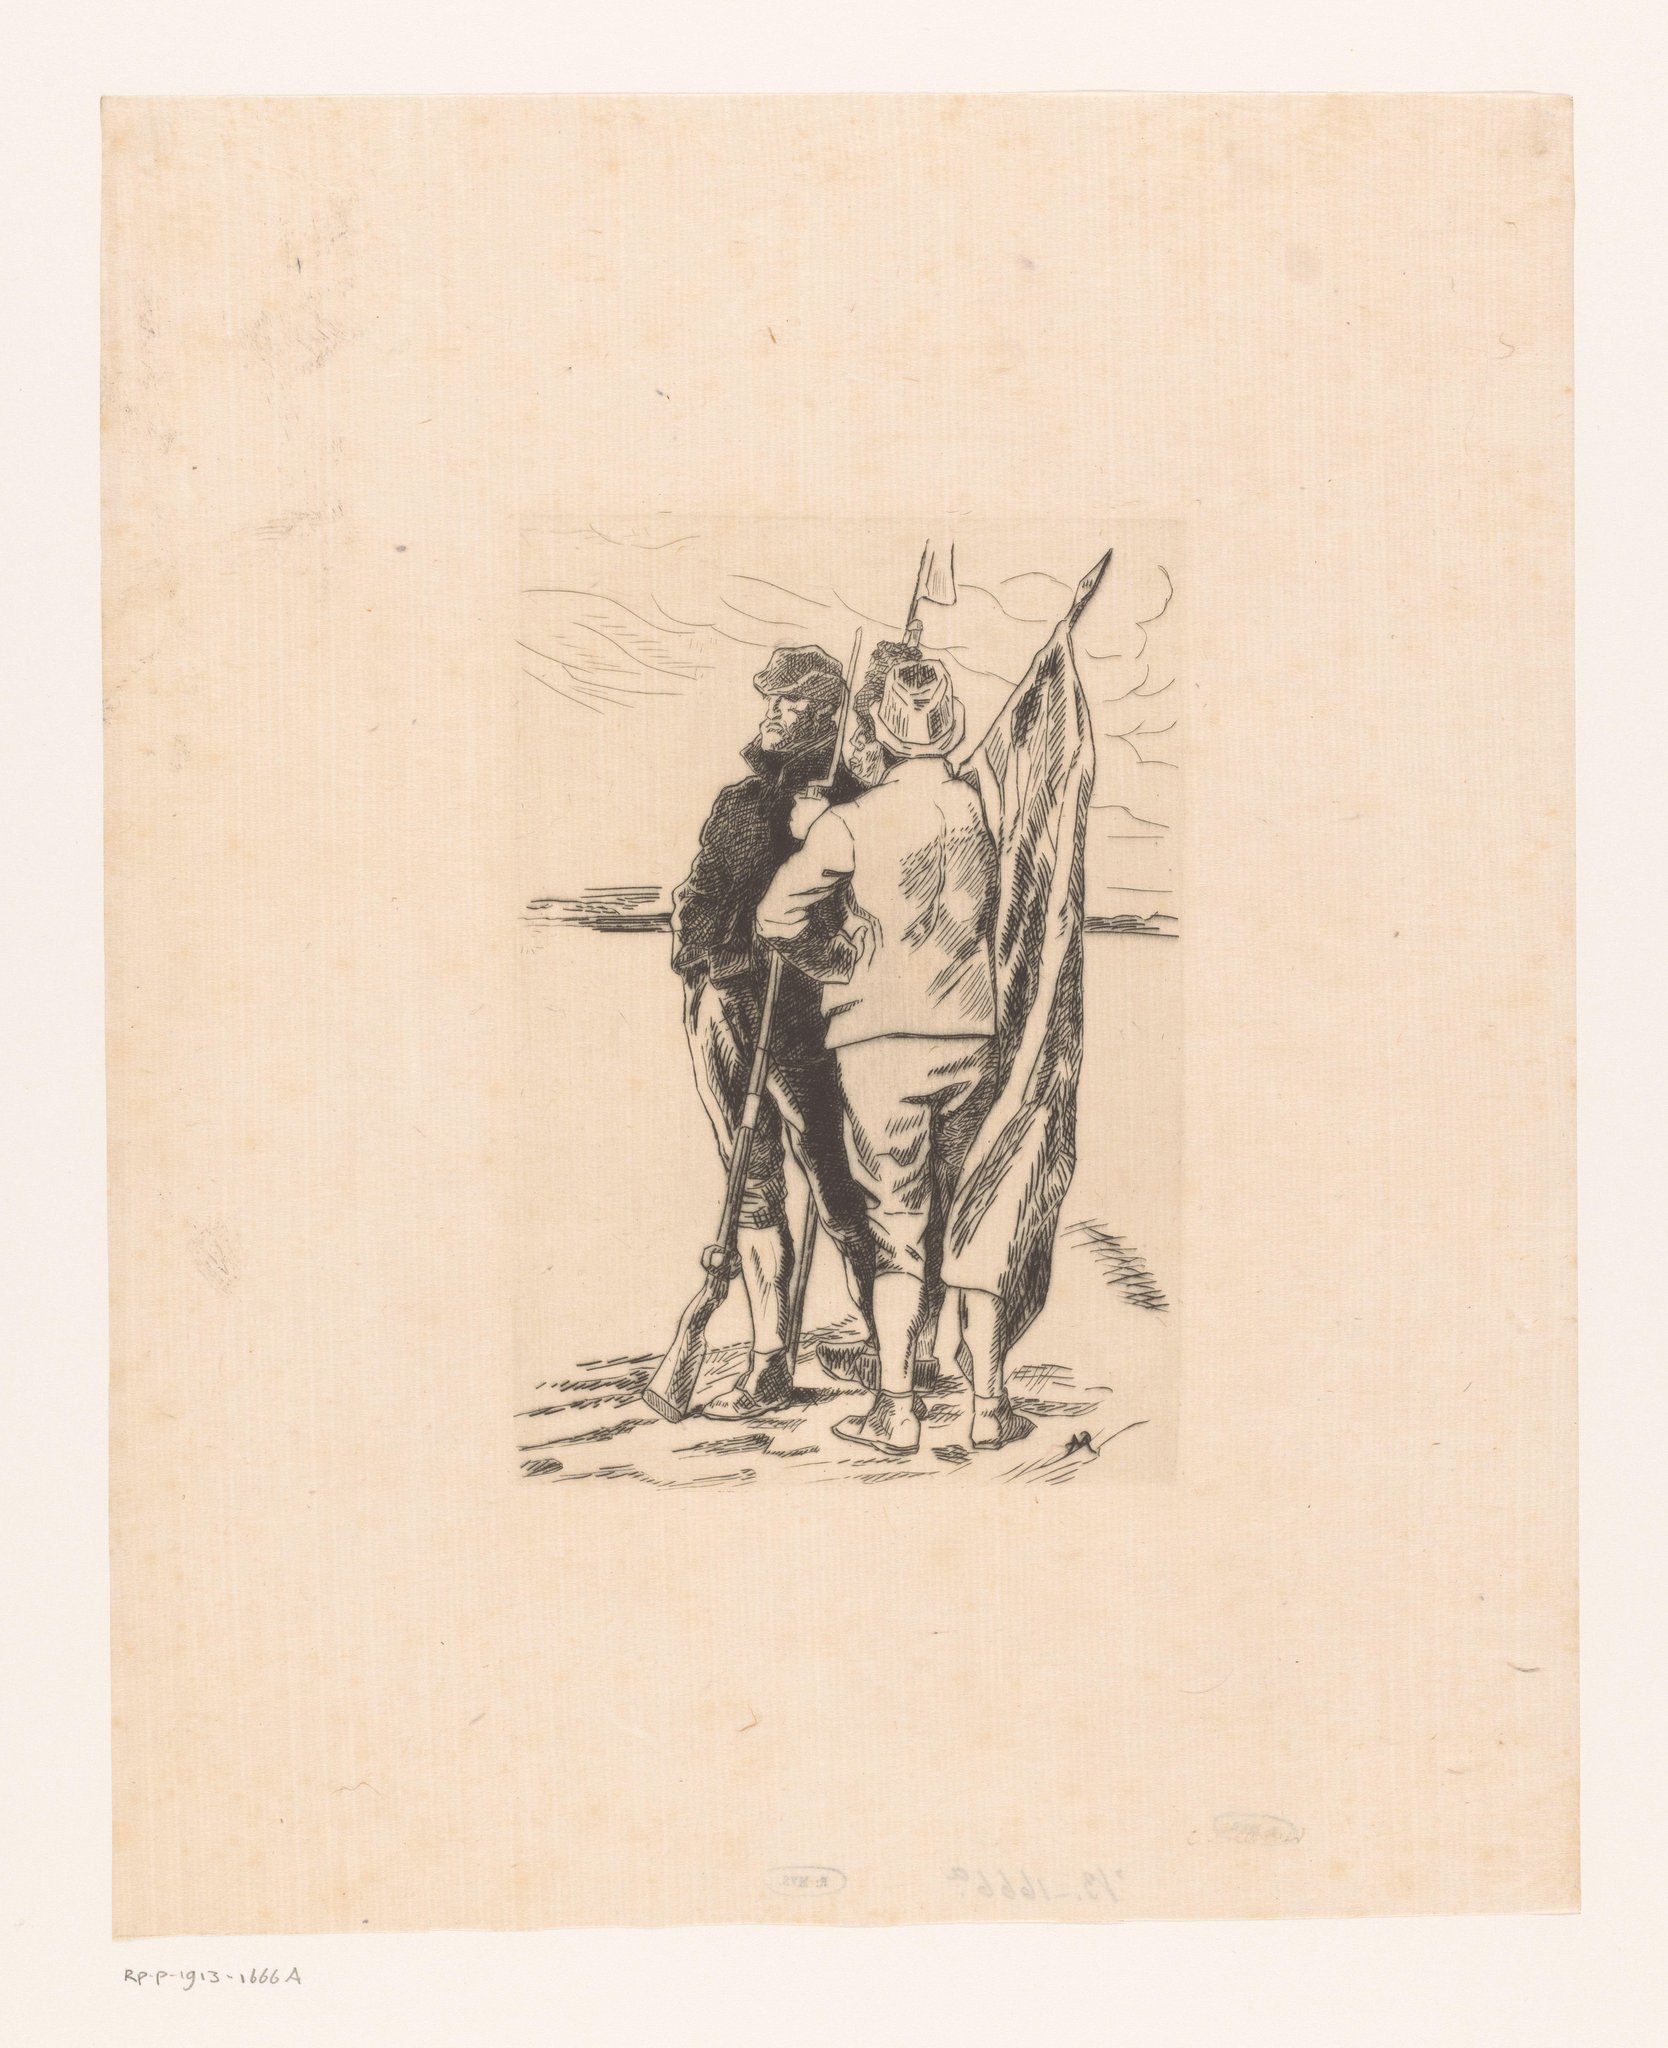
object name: print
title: Drie boeren met wapens en vaandels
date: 1841-1905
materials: paper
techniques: etching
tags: adult man, firearms: rifle, banner, standard (as symbol of the state, etc.)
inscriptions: collector's mark: Lugt 2228